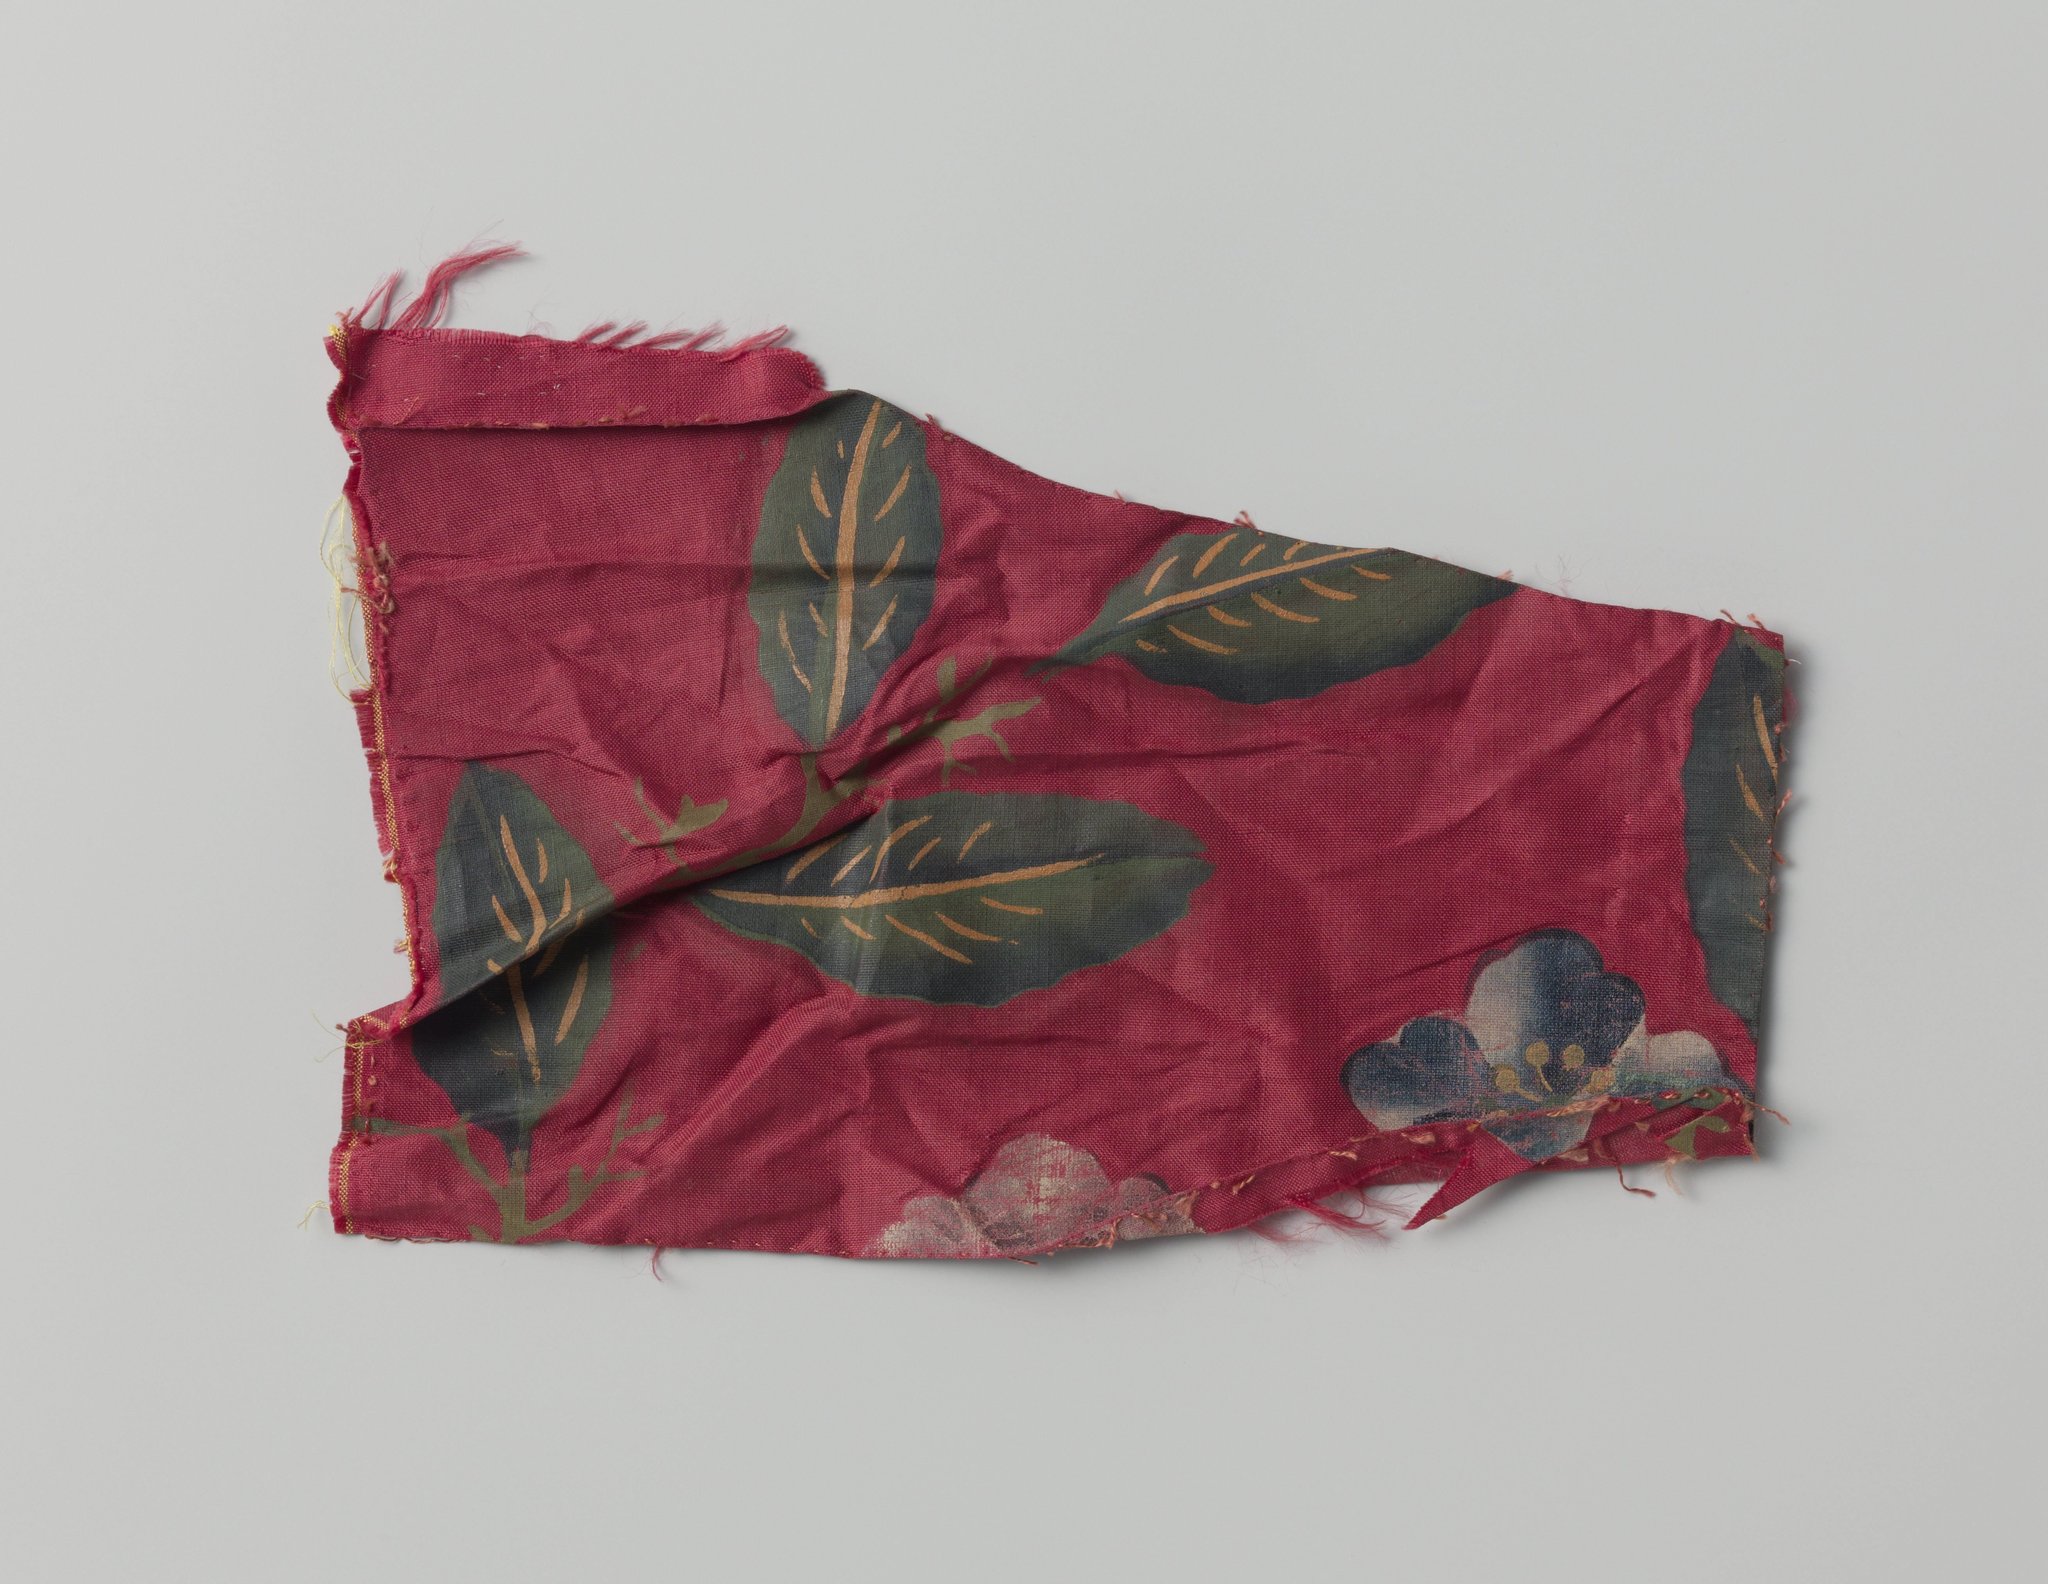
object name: covering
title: Fragment van een hoes voor stoelzitting, van bedrukte zijde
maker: Anonymous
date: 1770-1780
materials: linen, paint, silk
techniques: printing, weave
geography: france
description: Drie hoezen voor stoelzittingen. De hoezen zijn gemaakt van bedrukte zijde. Op een rode grond zijn veelkleurige bloemtakken gedrukt. De hoezen hebben een linnen voering.